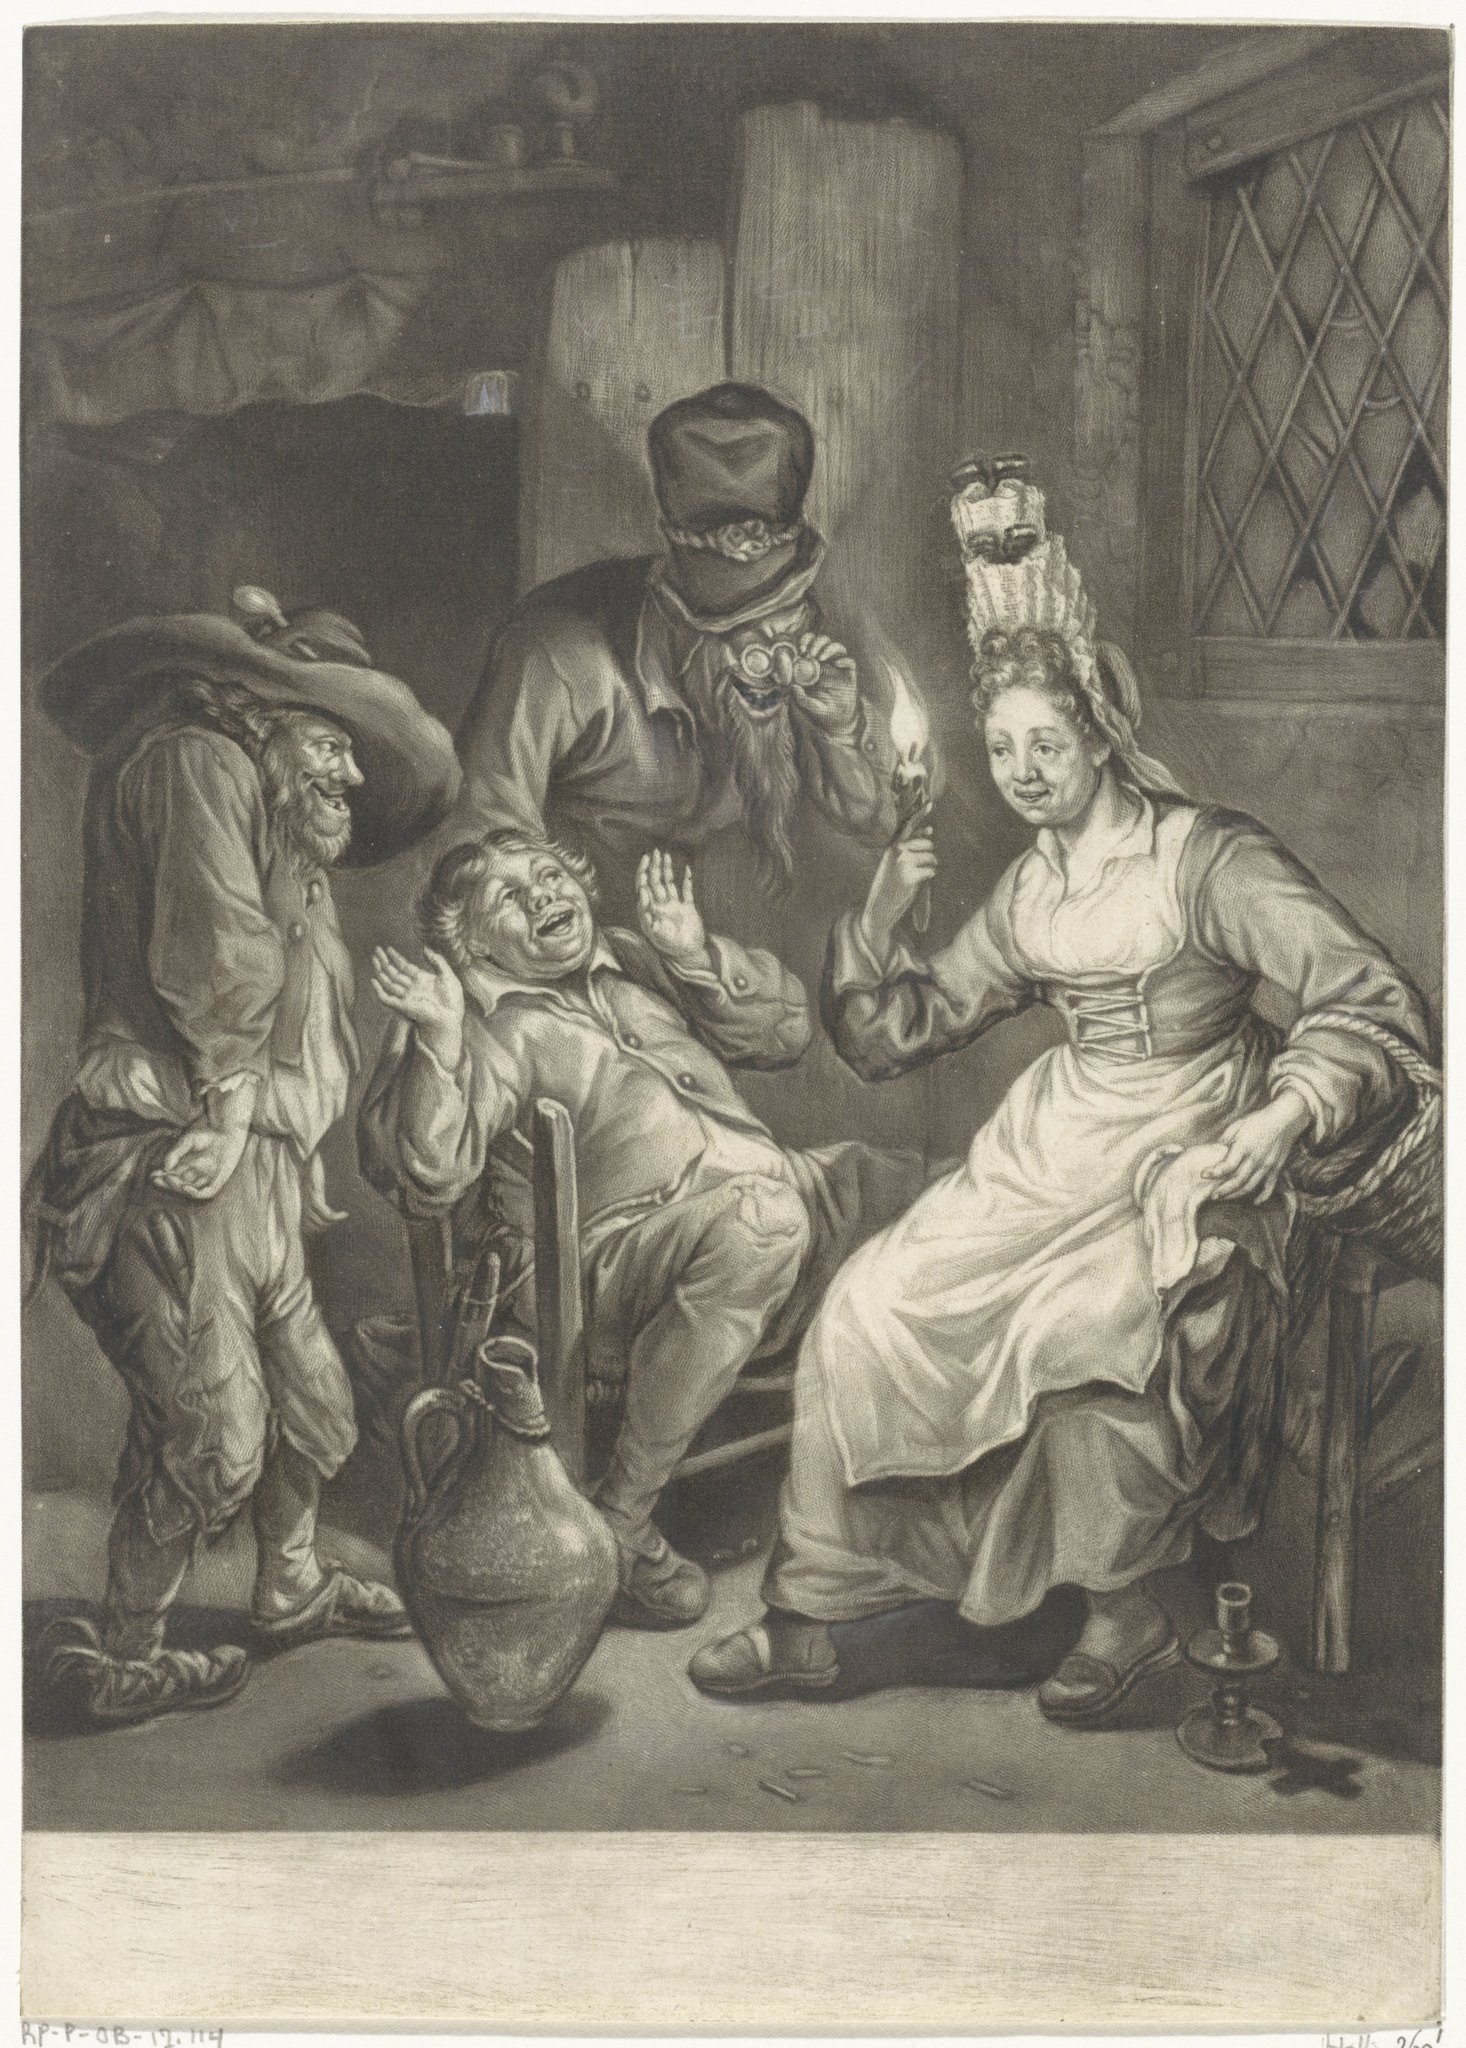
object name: print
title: Het gezicht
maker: jacob gole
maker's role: print maker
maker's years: 1660-1724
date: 1670-1724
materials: paper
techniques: mezzotint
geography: haarlem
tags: eyeglasses, spectacles, sight, looking (one of the five senses), candle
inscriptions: collector's mark: Lugt 240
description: Drie mannen bekijken een vrouw die een kaars vasthoudt. Een van de mannen draagt een bril. De prent maakt deel uit van een serie van vijf prenten met de vijf zintuigen.